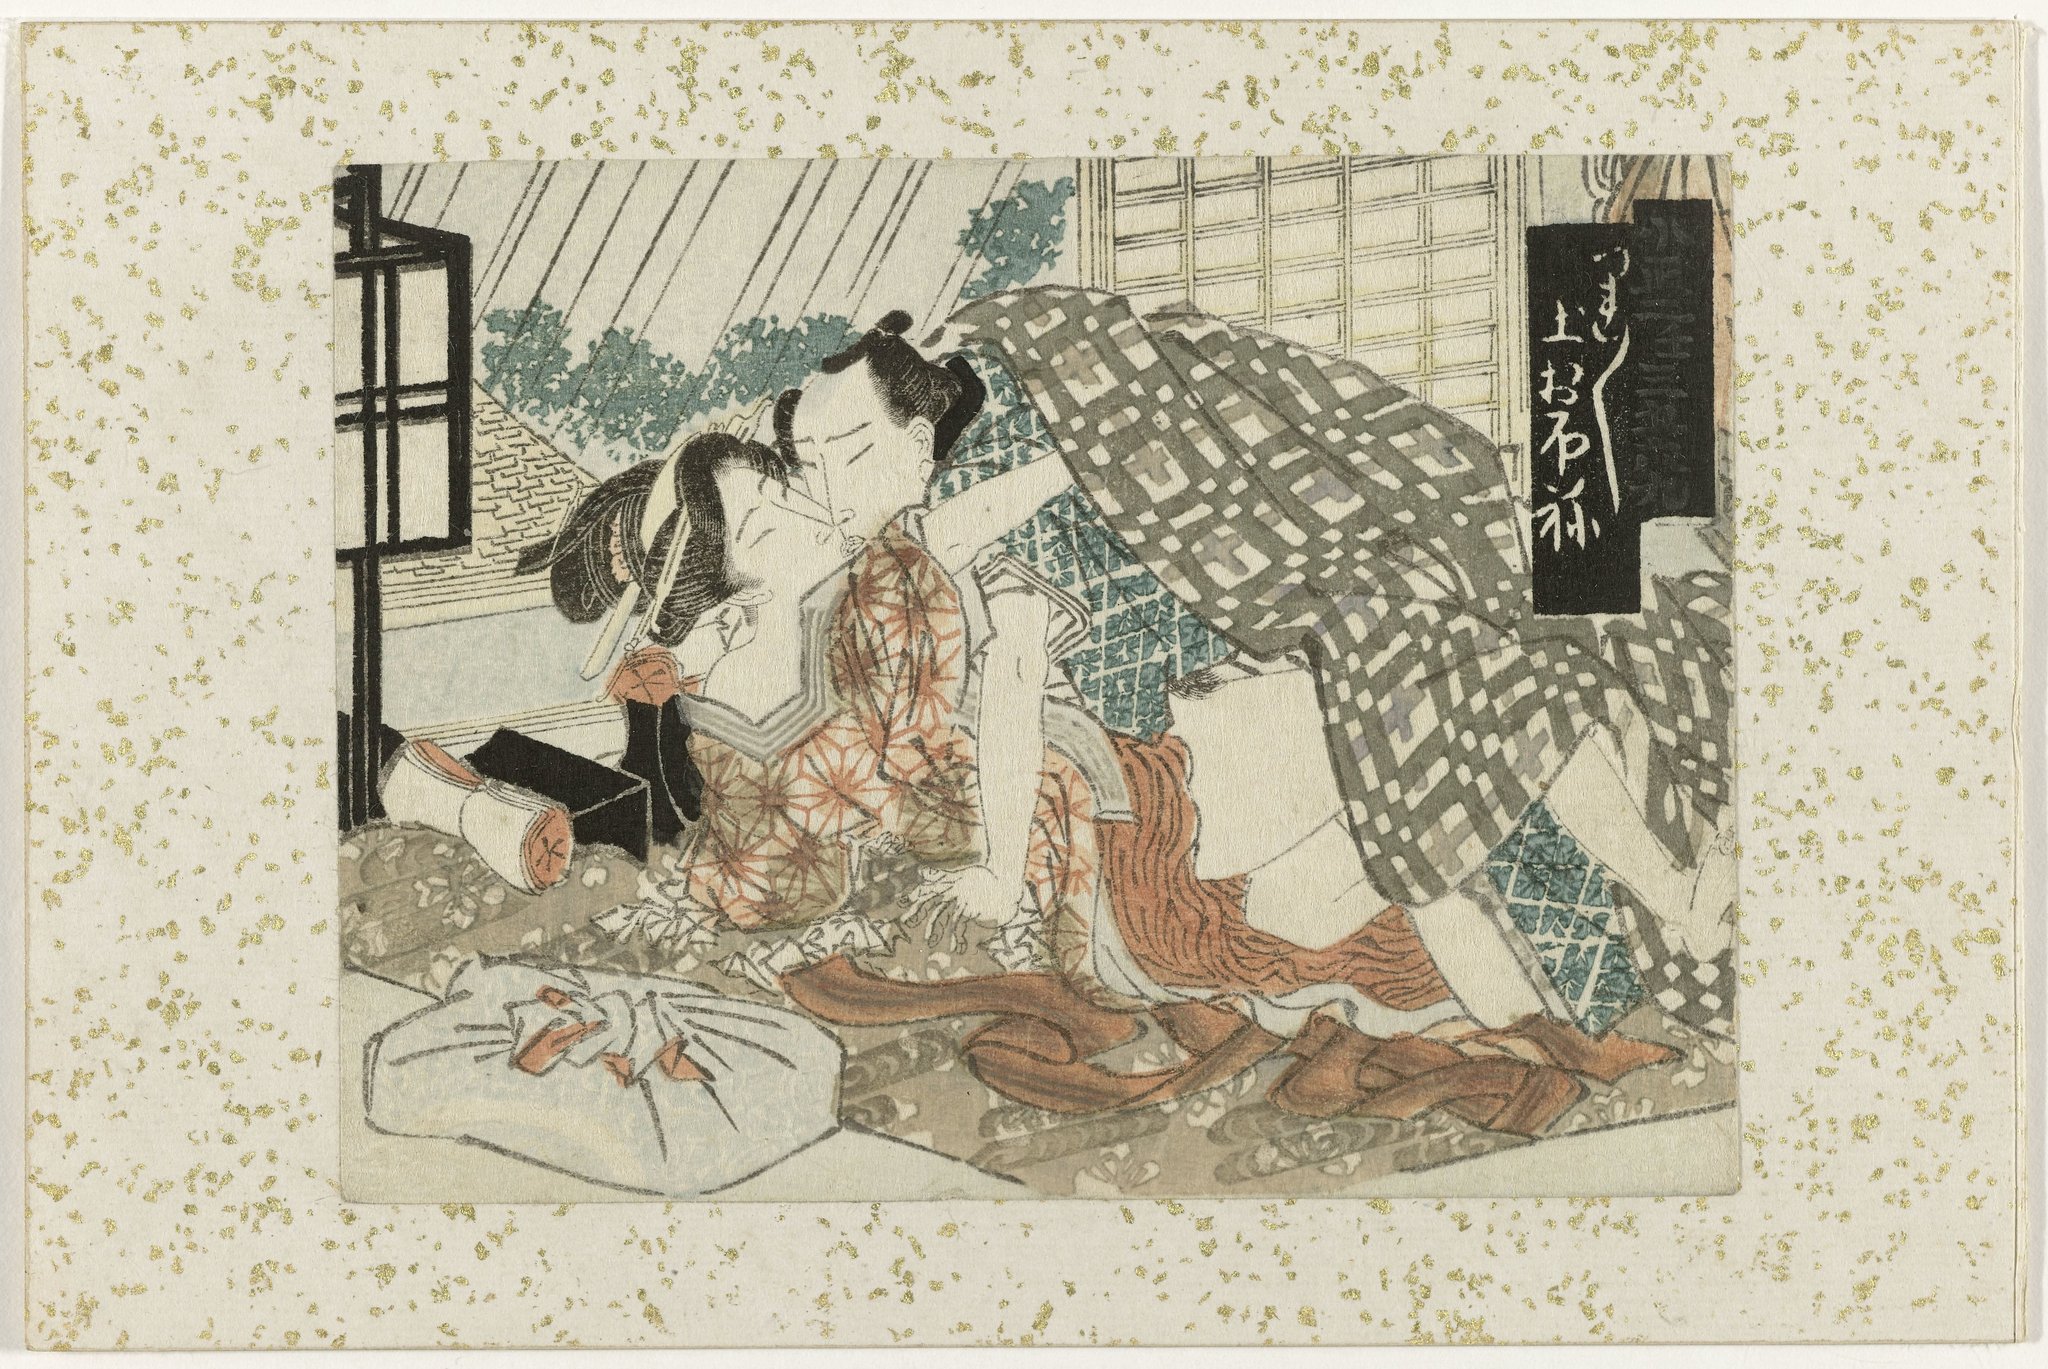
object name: shunga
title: Tsukizuki (de voorbijgaande tijd)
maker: Anonymous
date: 1830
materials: paper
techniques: woodcut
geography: japan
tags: containers, coitus, cohabiting, sexual intercourse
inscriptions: date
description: Een in een doek verpakte doos is neergezet terwijl het paar de liefde bedrijft. Op de zwarte cartouche zijn de korte maanden in zilver aangegeven, shô 1, 2 schrikkelmaand, 3, 5, 6, 9.